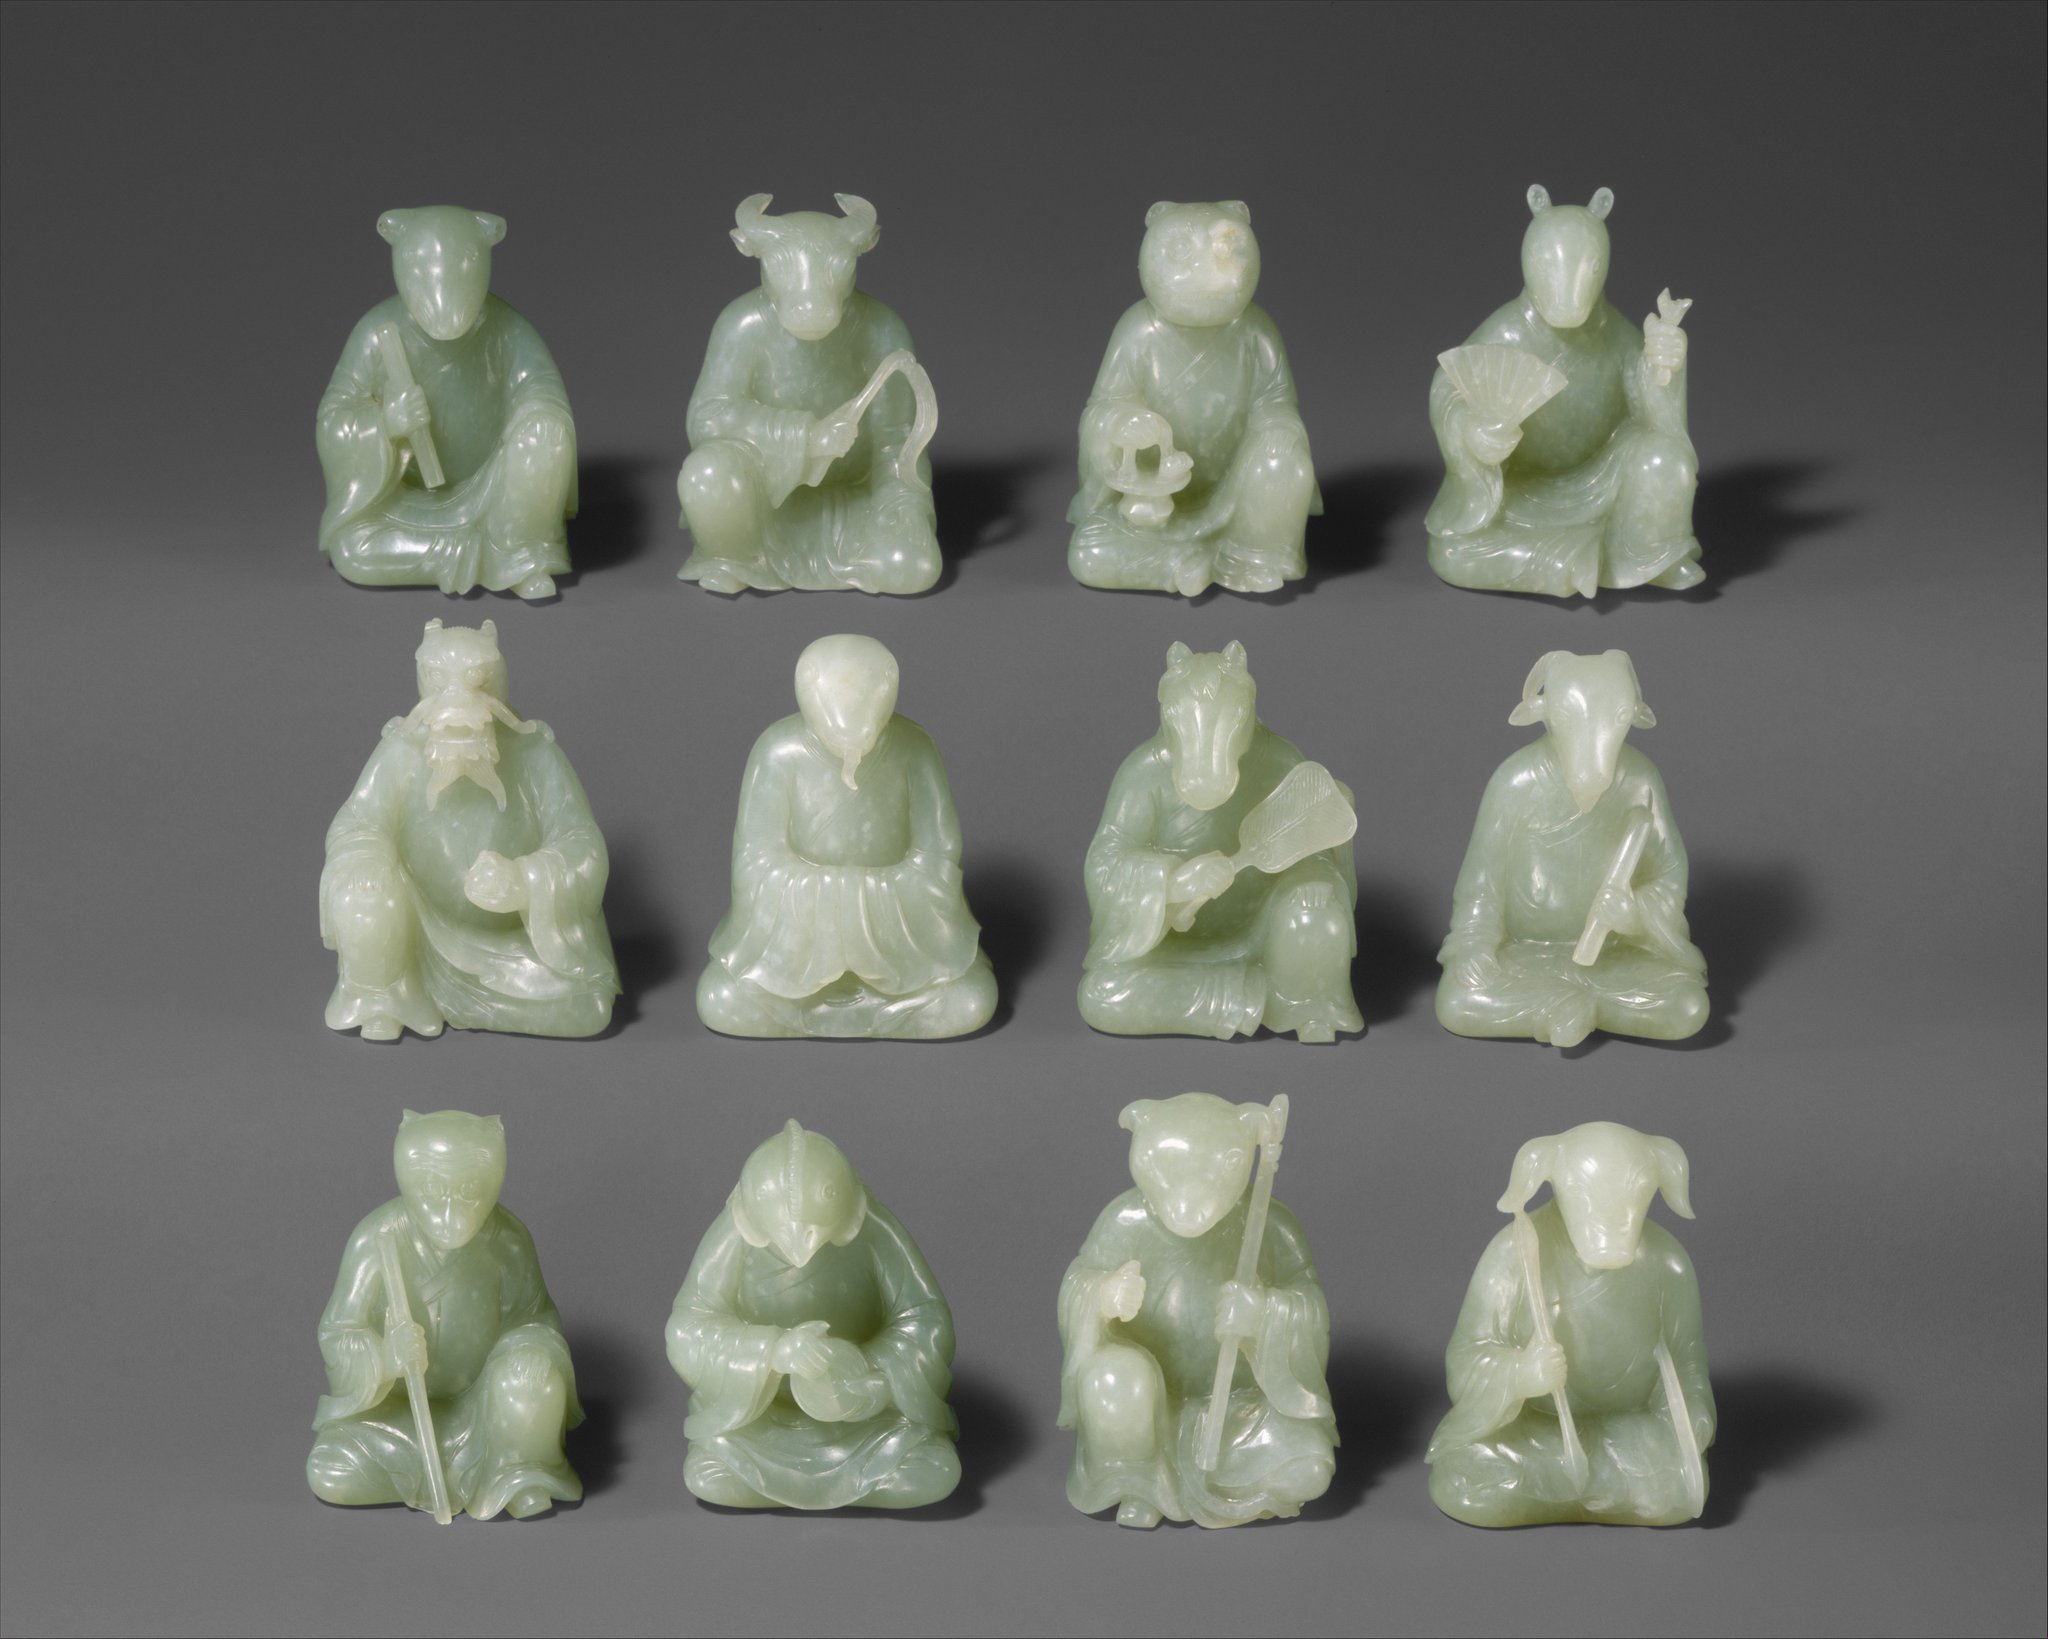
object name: zodiac symbol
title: Twelve animals of the Chinese zodiac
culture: chinese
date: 1701-1900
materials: jade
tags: animals,dragons,roosters,dogs,goats,horses,monkeys,pigs,rabbits,rats,snakes,tigers,zodiac,ox